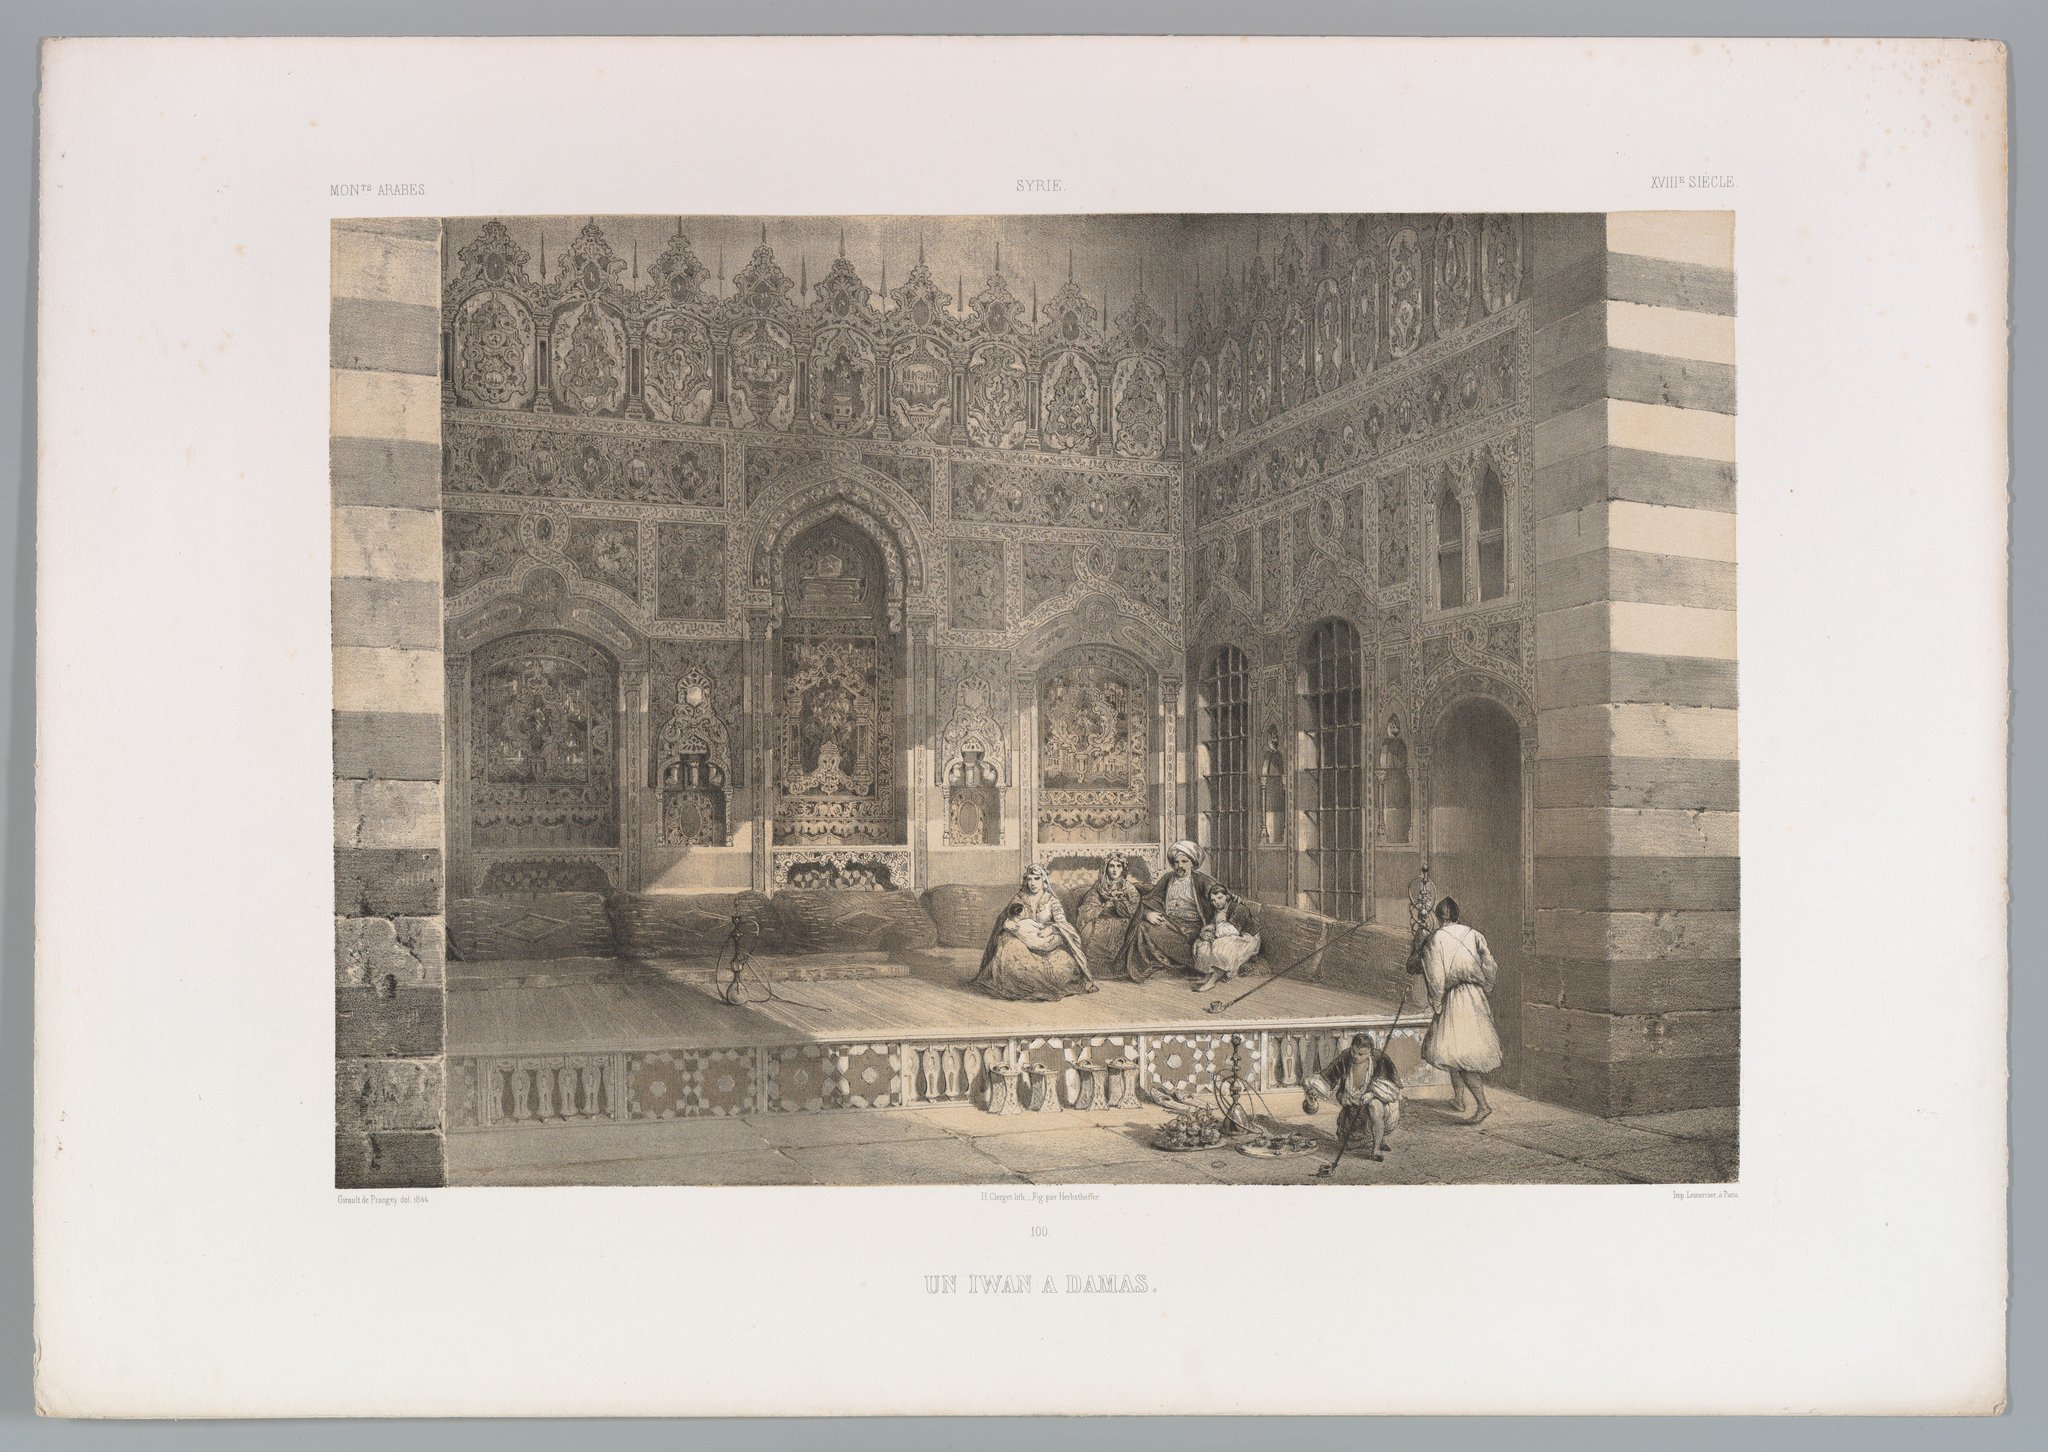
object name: lithograph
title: 100. Un Iwân, à Damas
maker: joseph-philibert girault de prangey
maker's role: artist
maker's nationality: french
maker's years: 1804-1892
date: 1843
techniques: lithograph